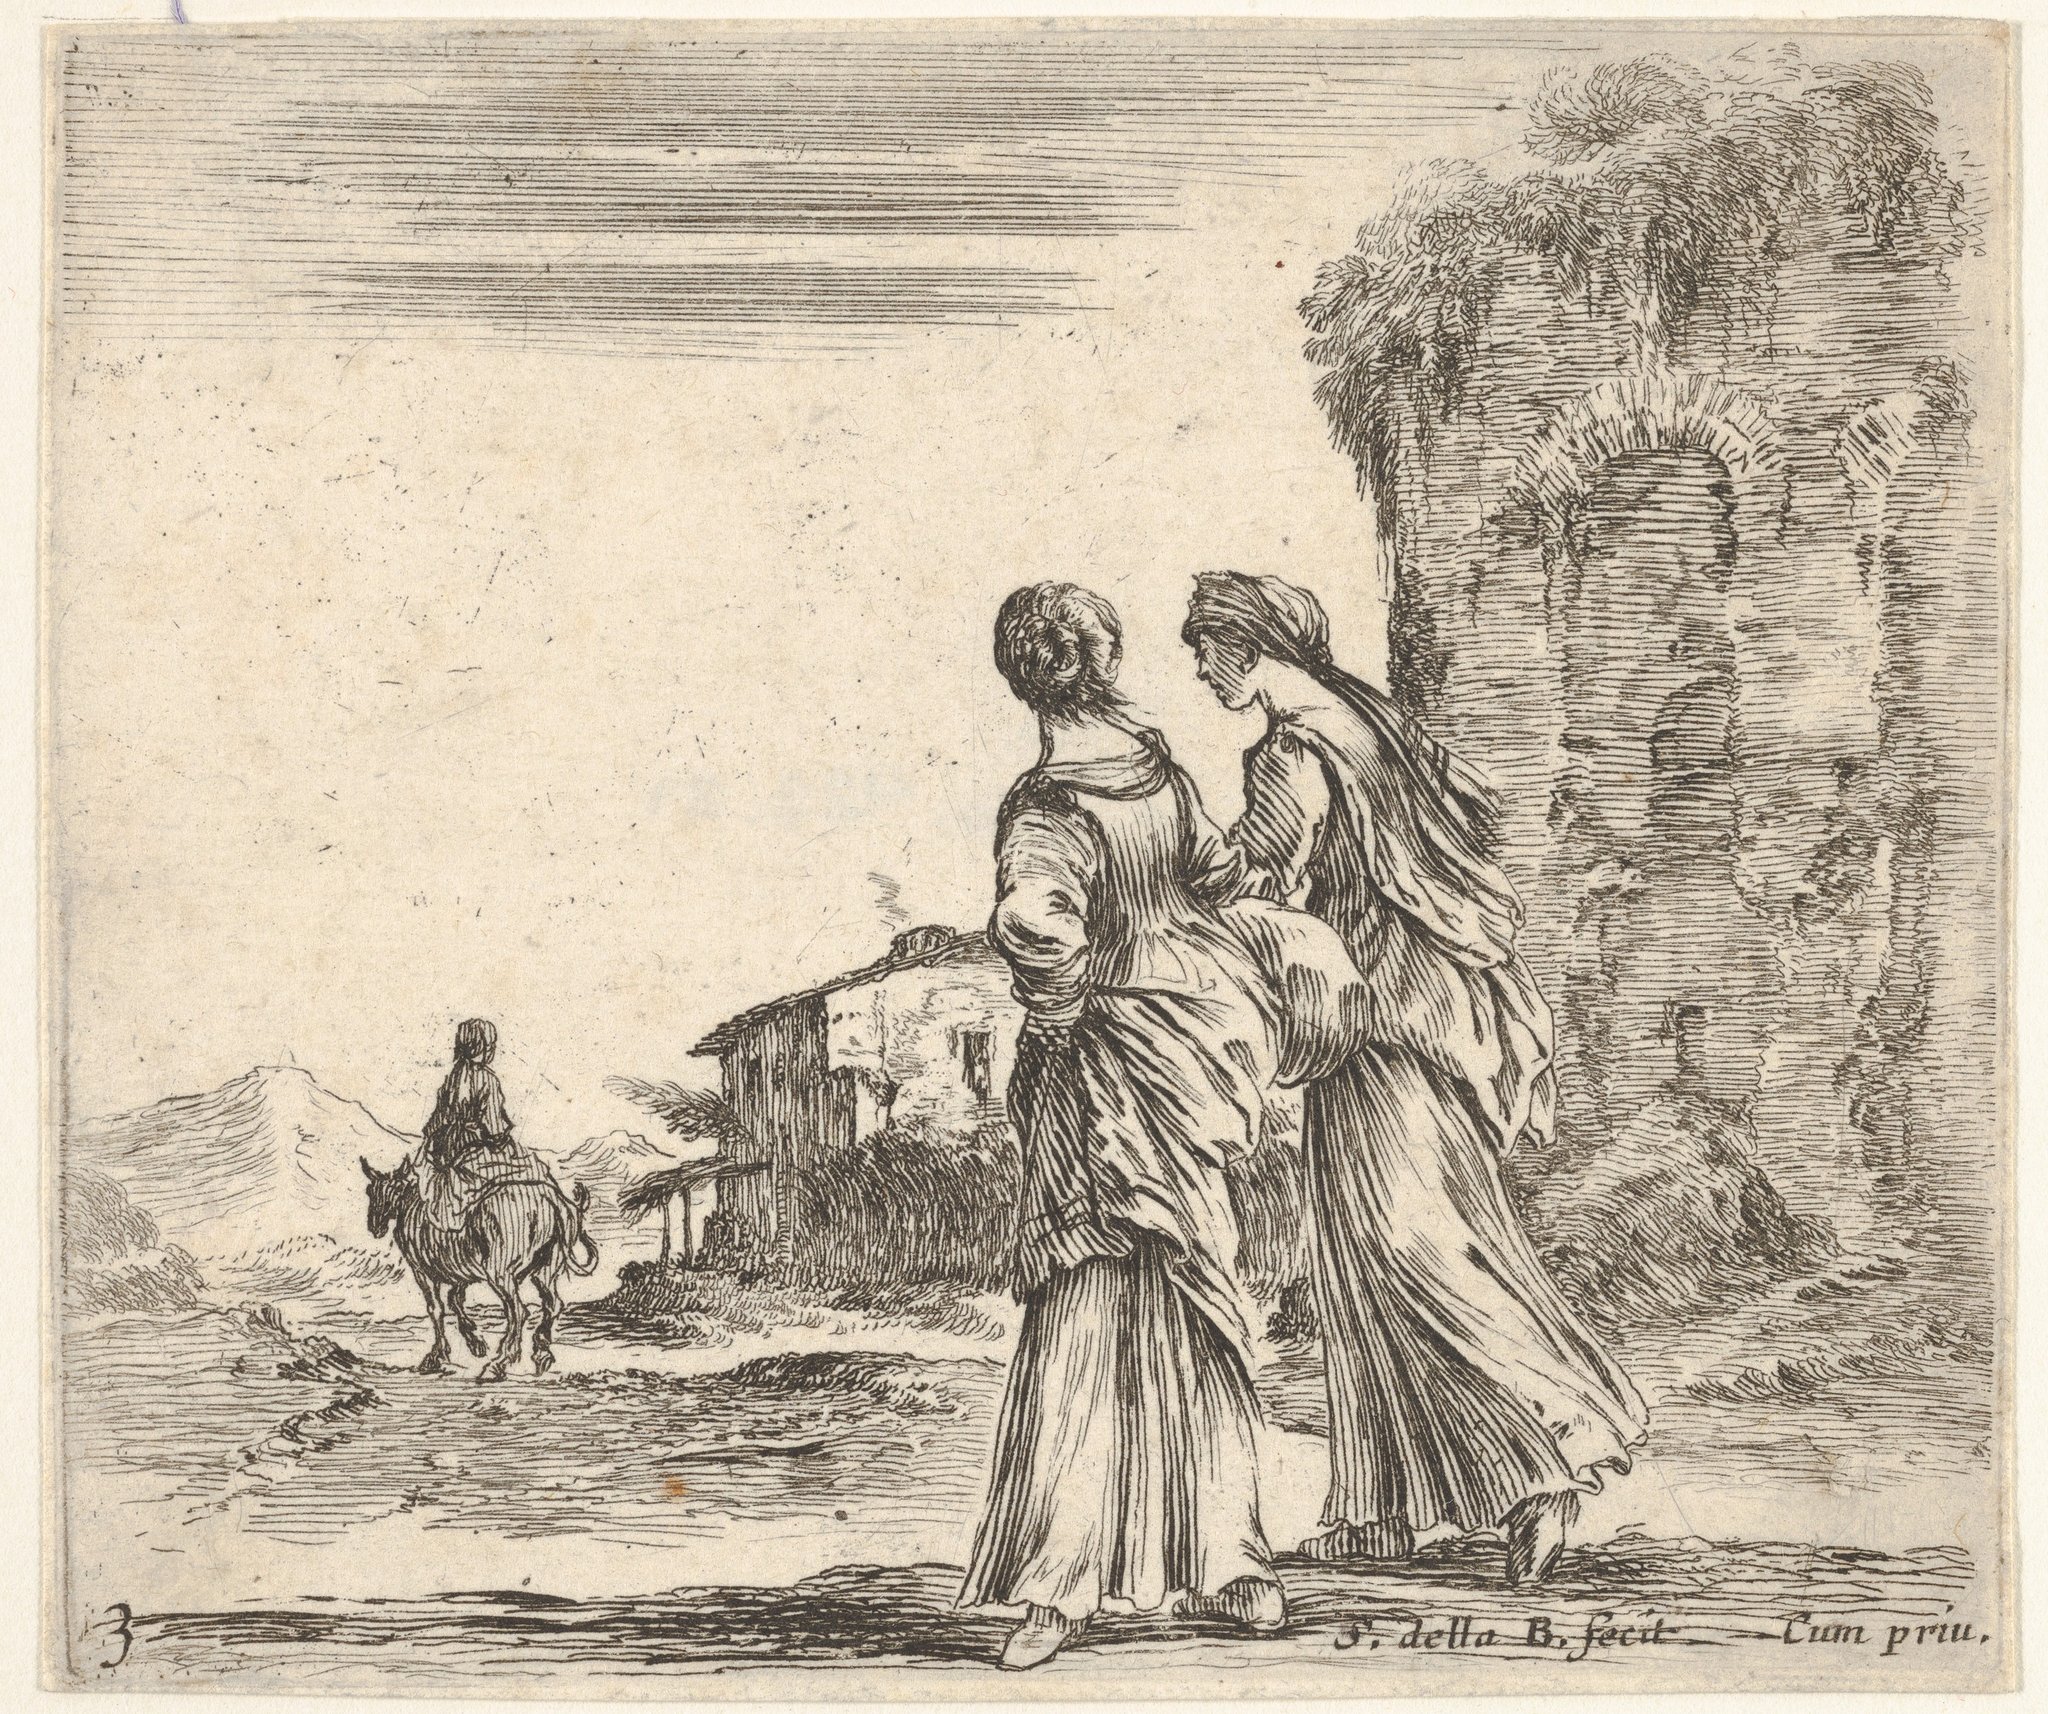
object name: print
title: Plate 3: two girls walking towards the left, seen from behind, a woman on a horse to left in background, from "Diversi Capricci"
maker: stefano della bella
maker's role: artist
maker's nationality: italian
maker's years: 1610-1664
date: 1644-1647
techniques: etching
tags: girls,women,walking,horses